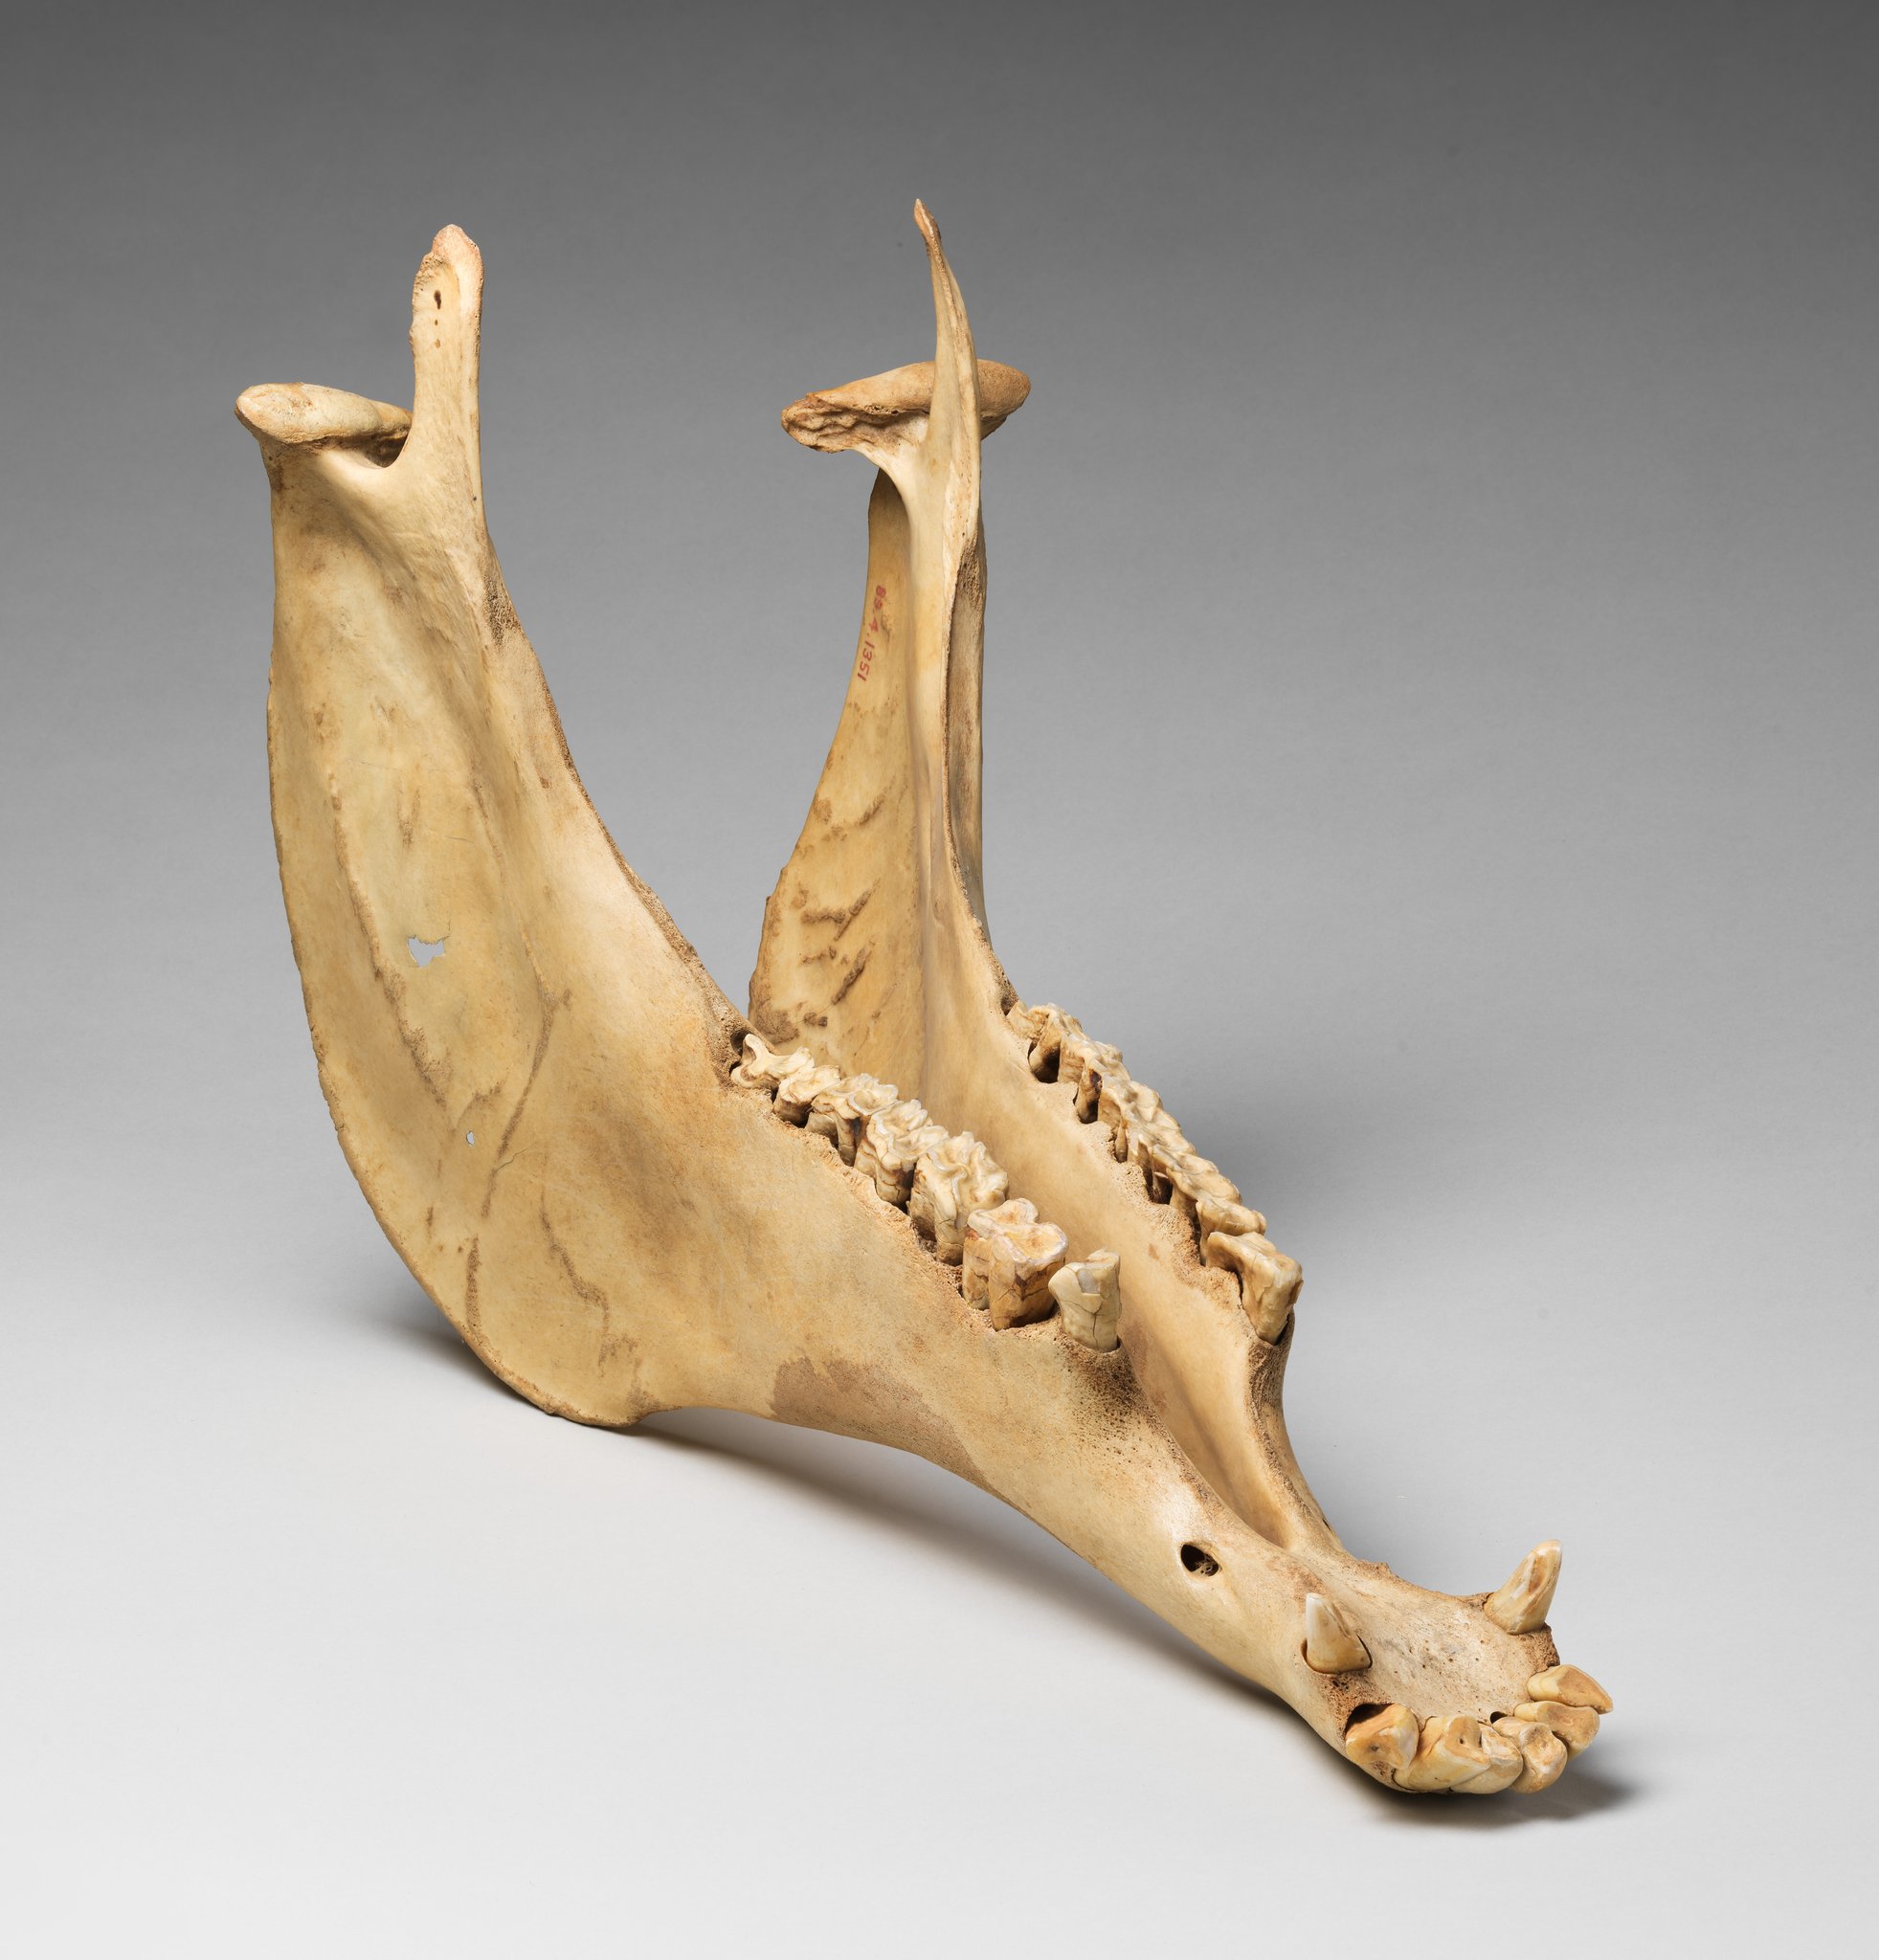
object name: jawbone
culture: american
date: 1801-1900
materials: bone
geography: united states